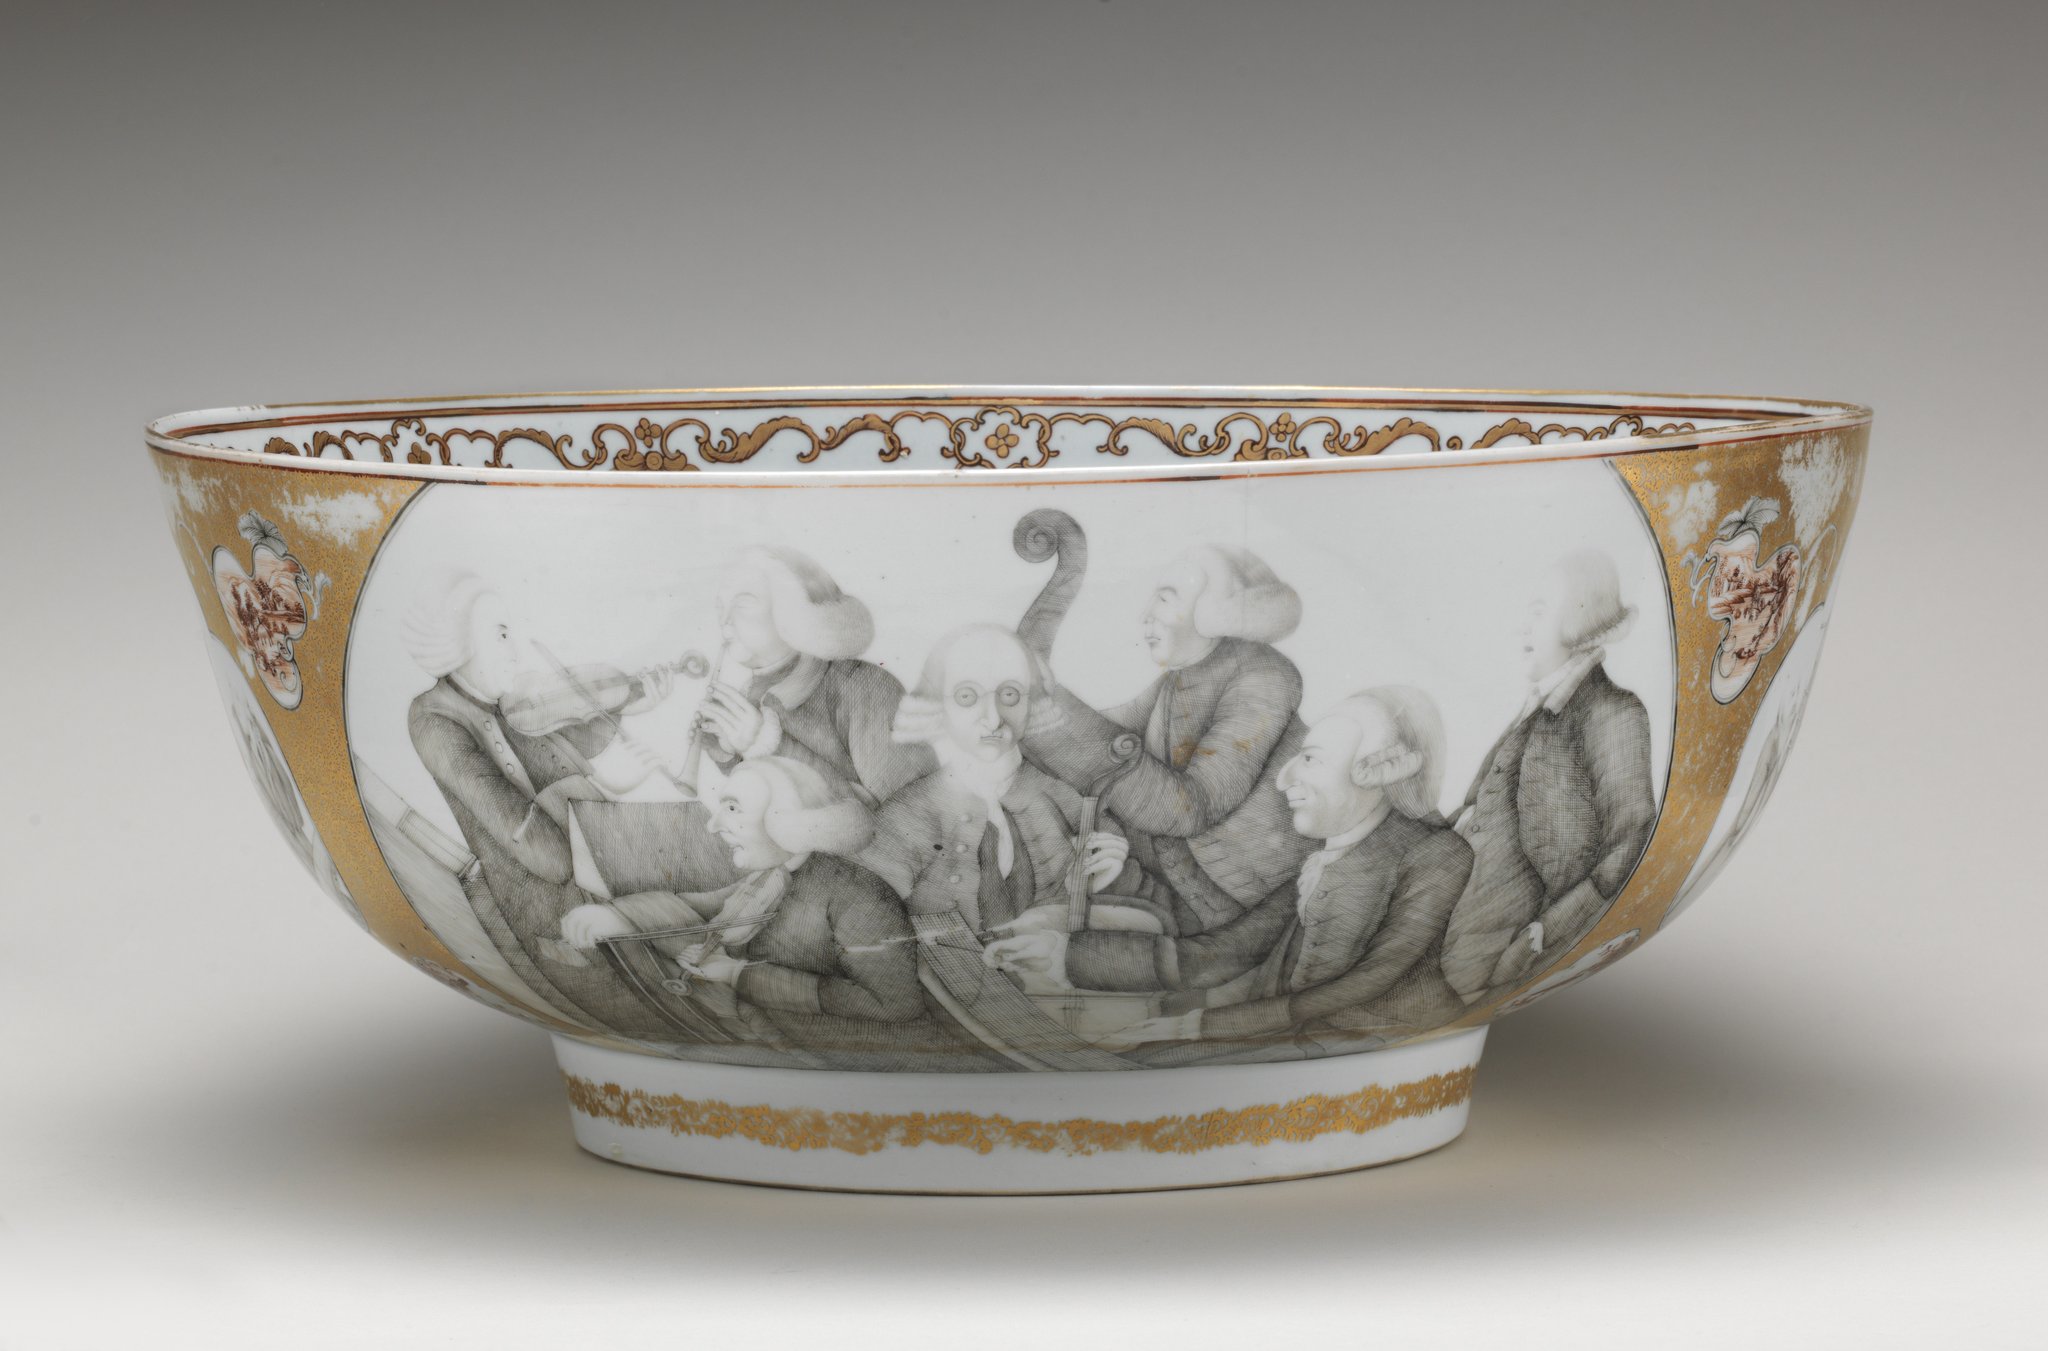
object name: punch bowl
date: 1760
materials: hard paste porcelain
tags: musical instruments,men,musicians